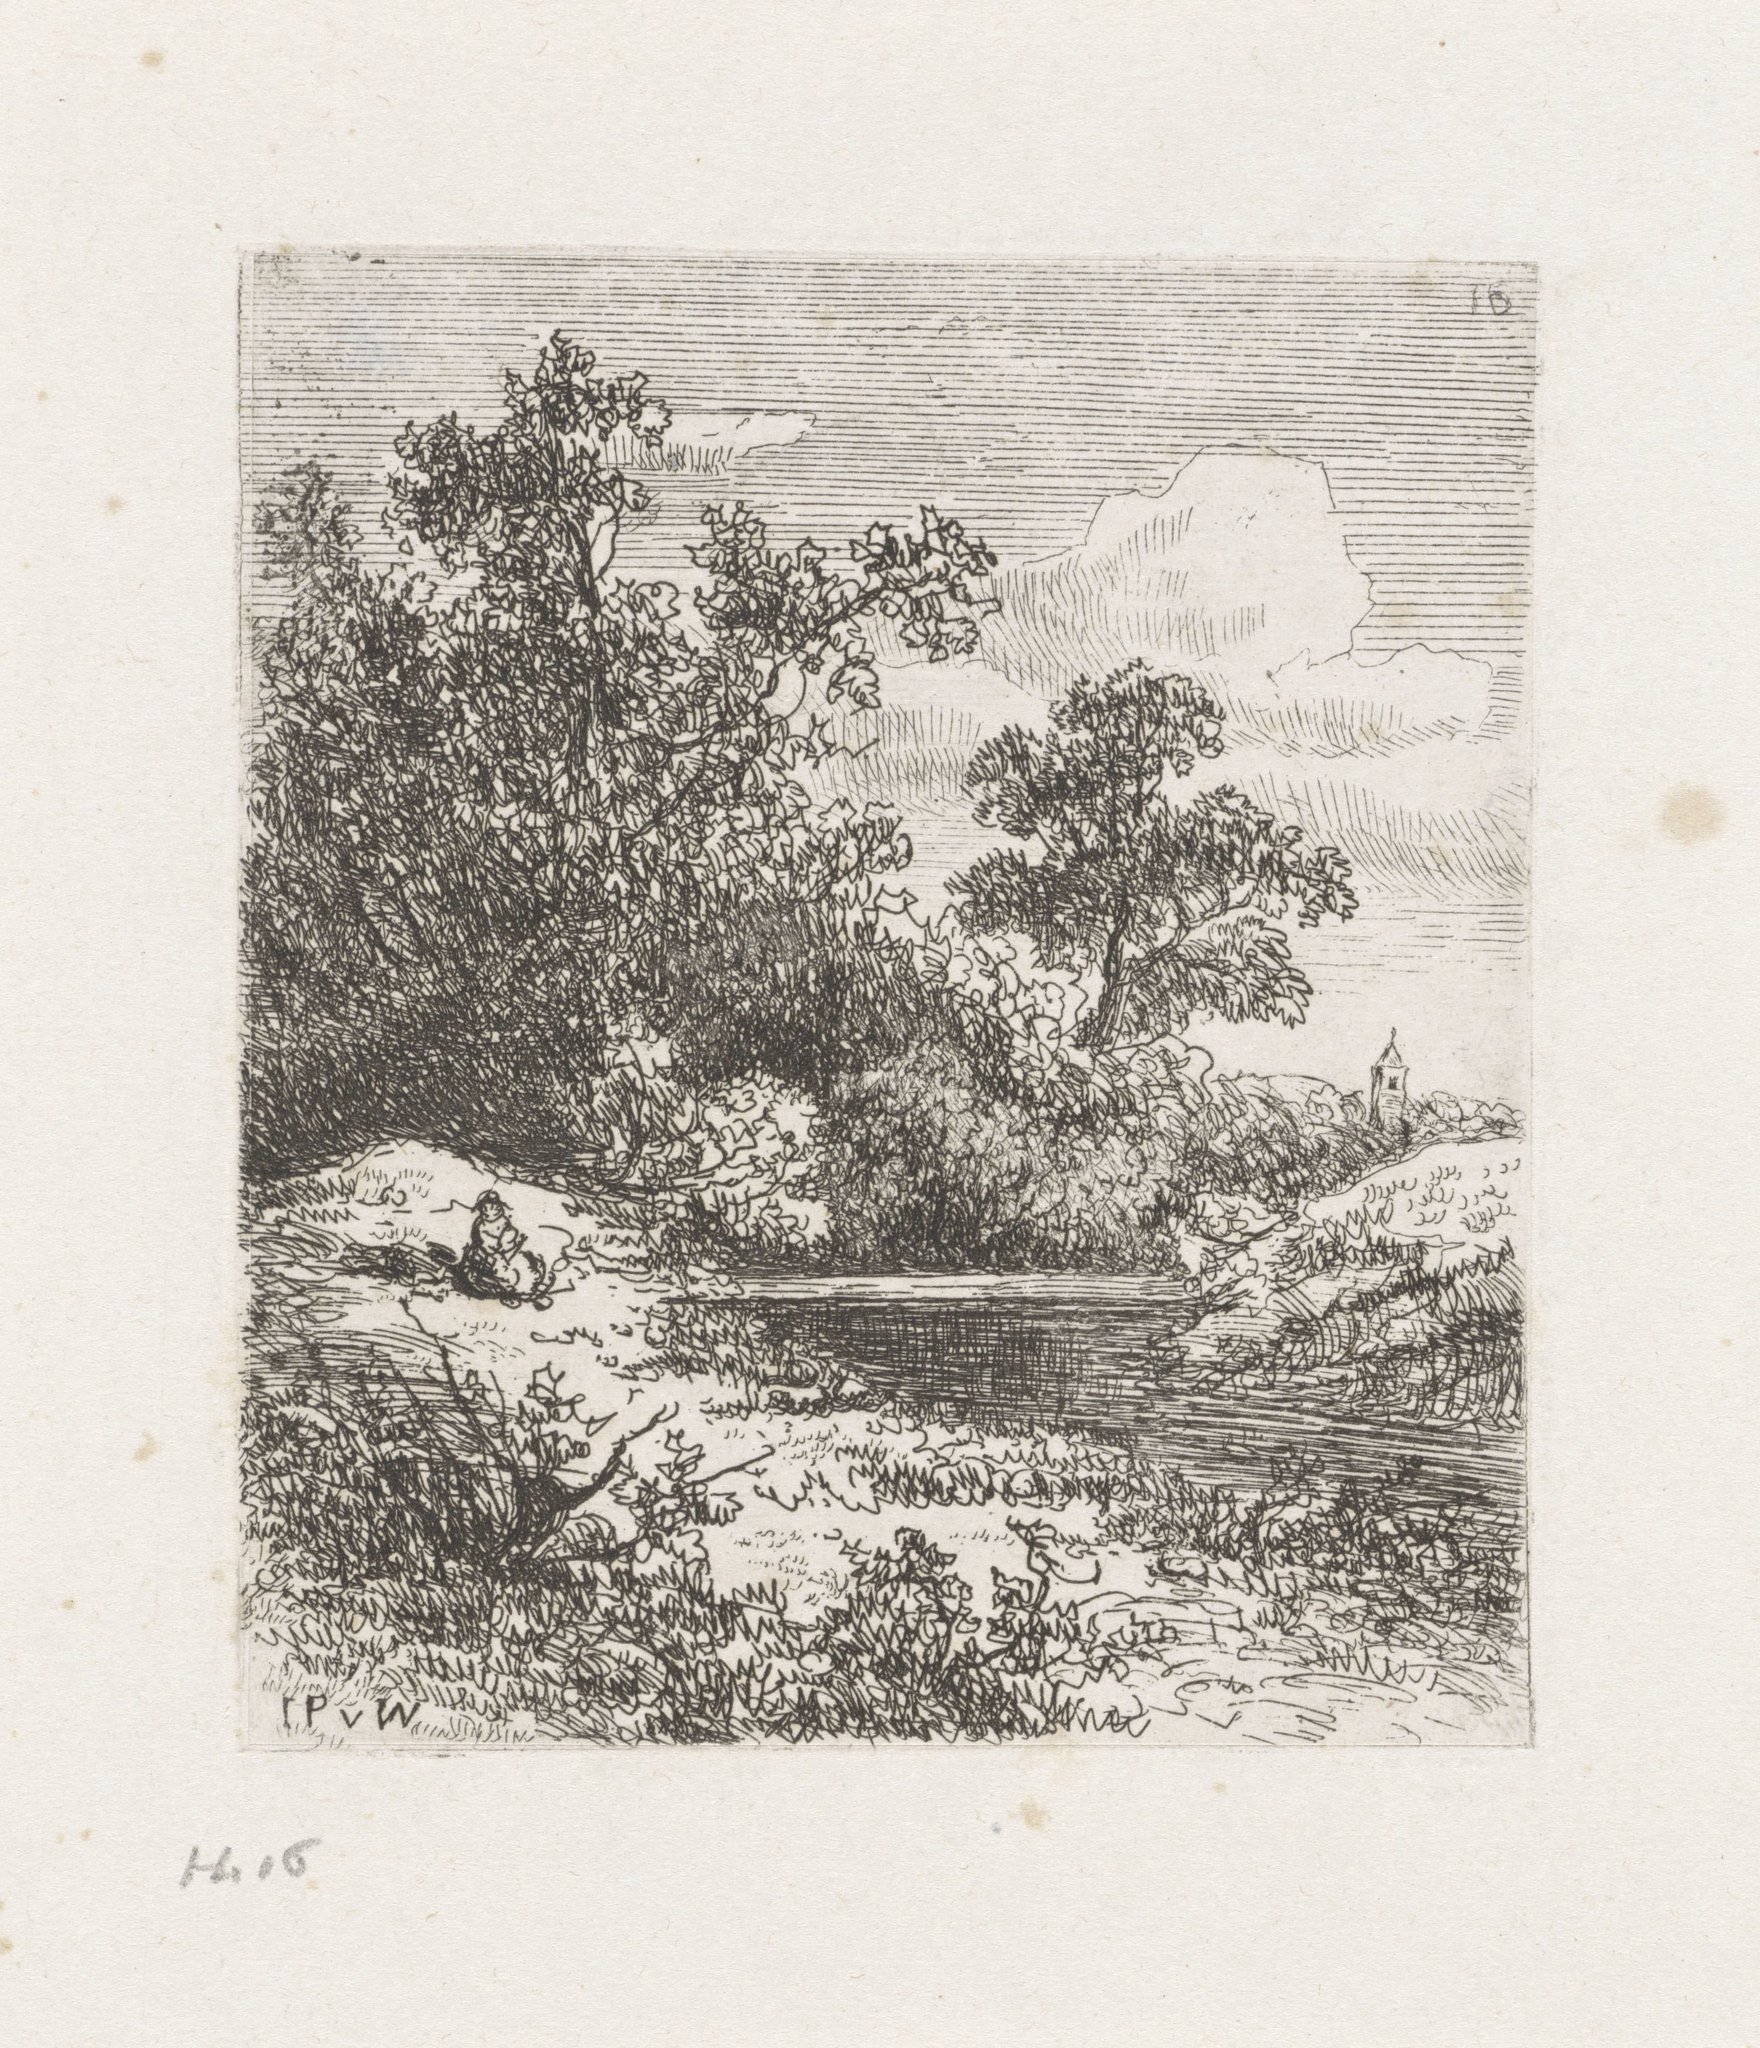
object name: print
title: Vrouw aan de oever van een rivier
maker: johannes pieter van wisselingh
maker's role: draughtsman, painter, print maker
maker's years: 1812-1899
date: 1830-1878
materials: paper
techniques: etching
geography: netherlands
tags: tower, clock tower ~ monumental adornment, river, sitting on the ground - aa - female human figure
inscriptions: collector's mark: Lugt 2228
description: Aan de oever van een rivier zit een vrouw. Achter haar enkele bomen en rechts in de verte een klokkentoren. Rechtsboven het getal 16.